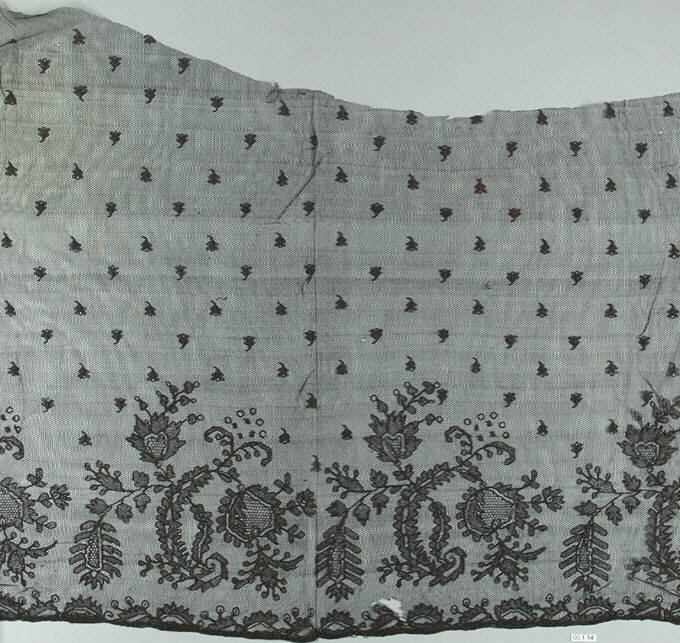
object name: veil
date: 1850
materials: silk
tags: flowers